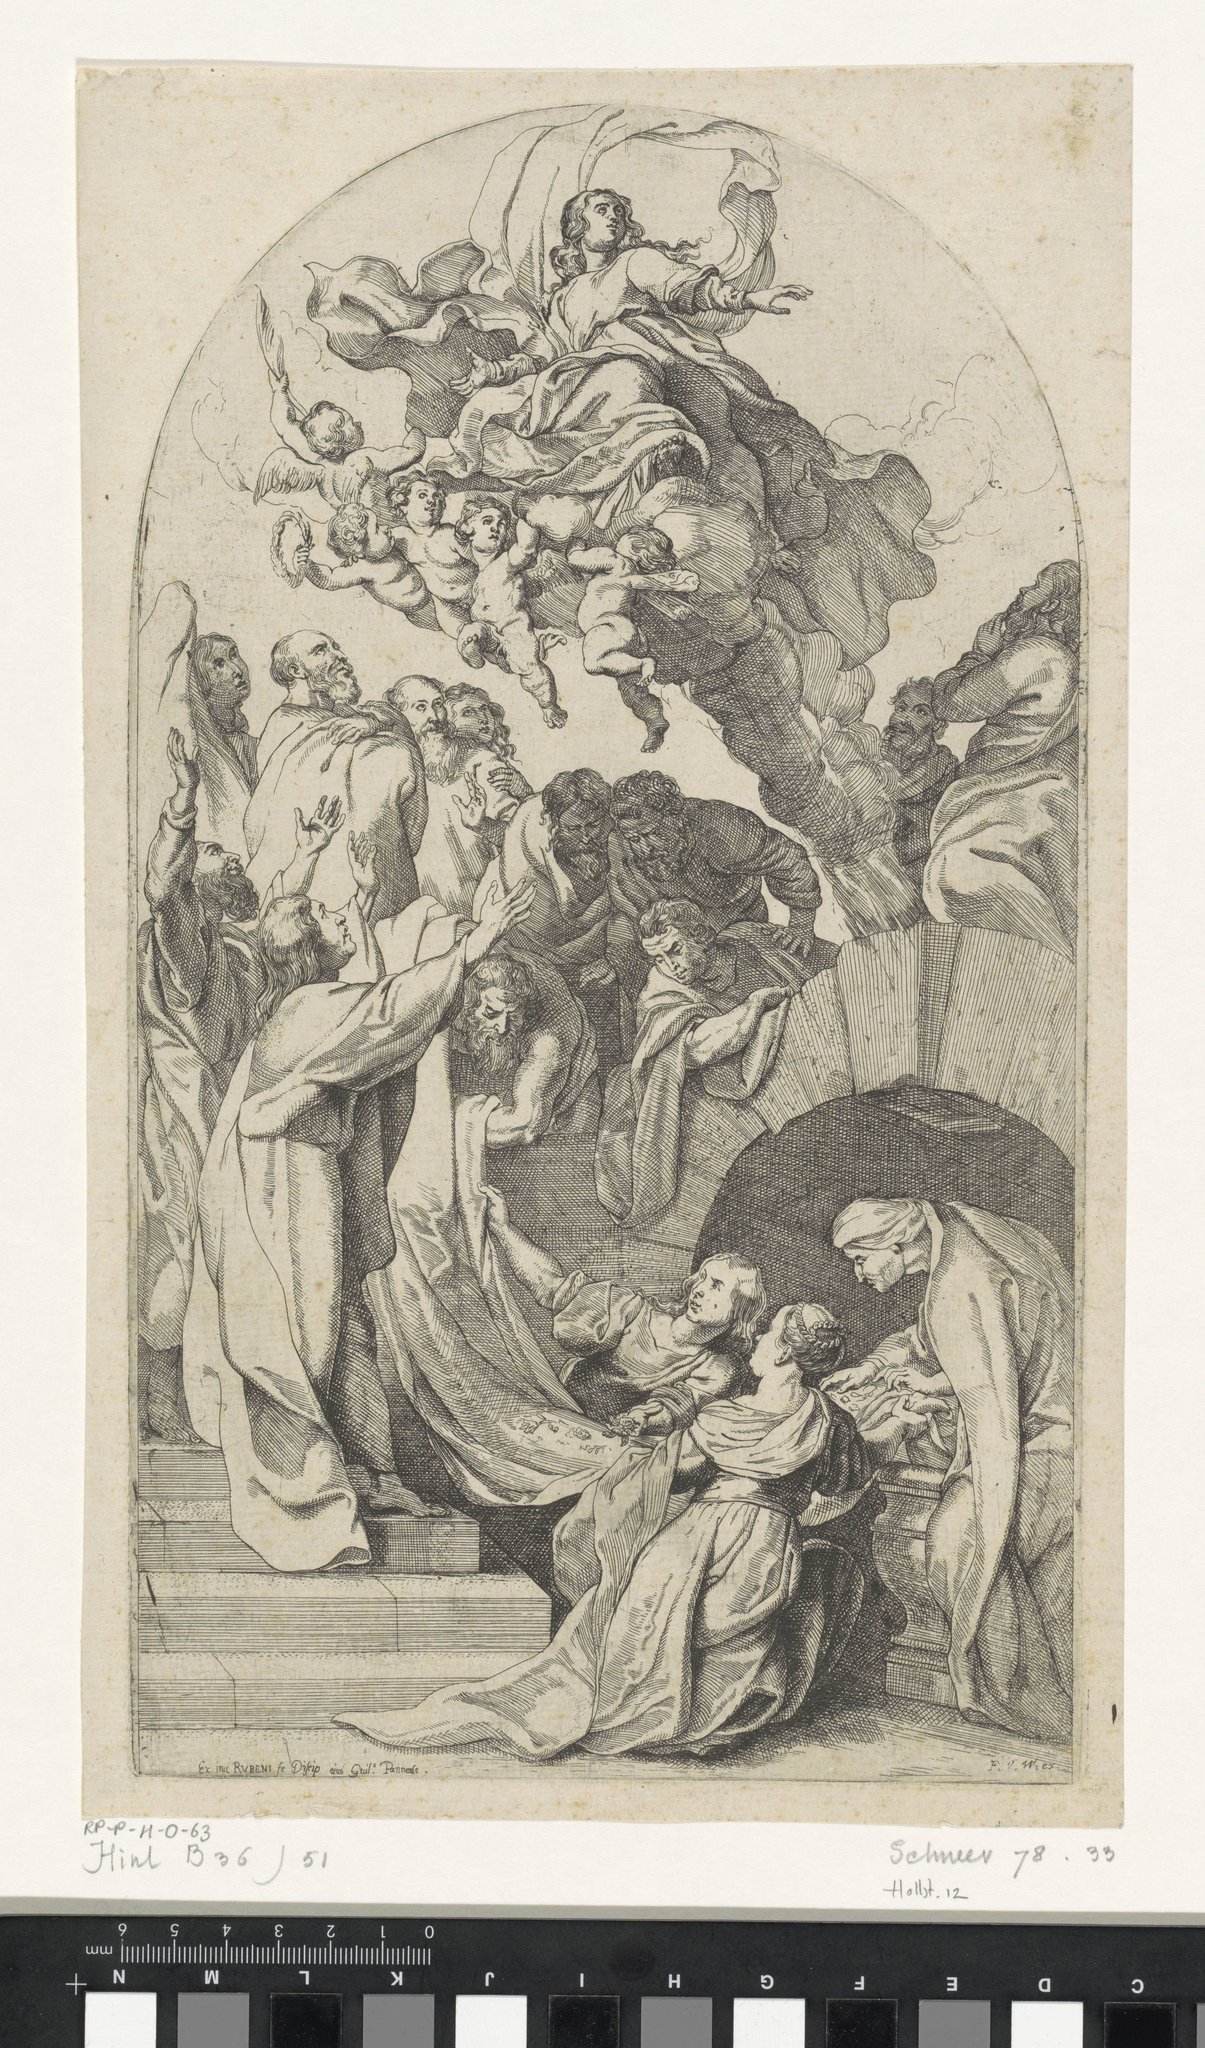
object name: print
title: Hemelvaart van Maria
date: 1610-1634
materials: paper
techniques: etching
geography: antwerp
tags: the assumption of mary ('assumptio corporis'): she is borne into heaven by angels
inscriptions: collector's mark: Lugt 11, collector's mark: Lugt 10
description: Rondom het graf van Maria de verzamelde apostelen. In de wolken boven hen wordt Maria door engelen meegevoerd naar de hemel.